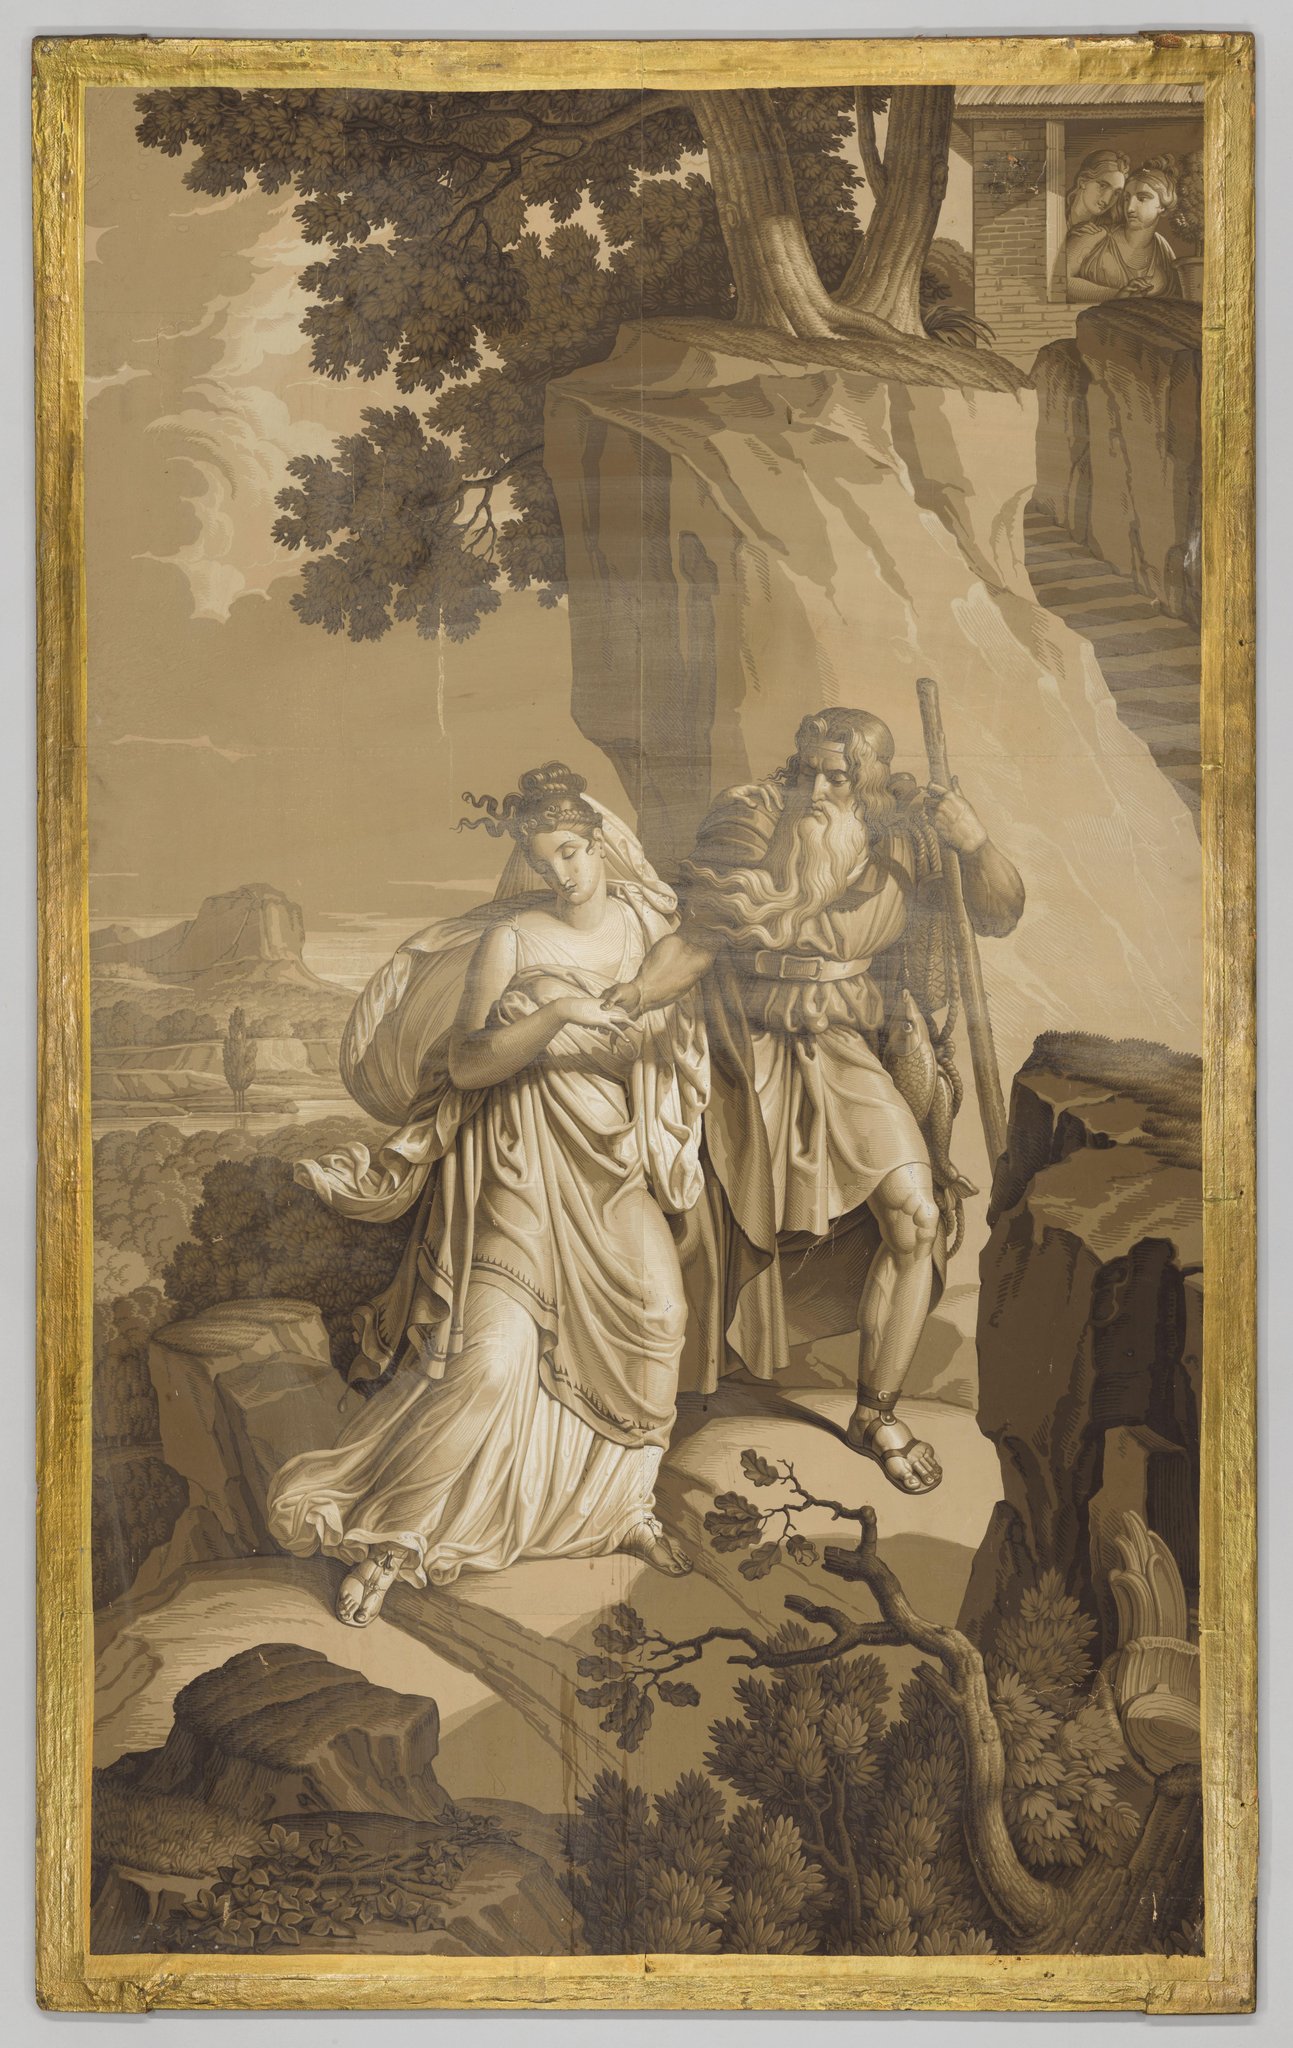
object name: interieuronderdeel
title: Behangsel, paneel, met voorstelling uit "Les Amours de Psyche": Psyche op in rotsen uitgehouwen trap, in grisailletinten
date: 1816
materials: paper, wood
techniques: printing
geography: paris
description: Paneel van op papier "geschilderd" behangsel met een voorstelling uit "Les Amours de Psyche", uitgevoerd in grisailletinten. Voorafgegaan door een visser bestijgt Psyche een in de rotsen uitgehouwen trap. Rechts kijken twee vrouwen op het tafereel neer; links een vergezicht. Gedrukt door Joseph Dufour. Zie tevens: BK-16121.